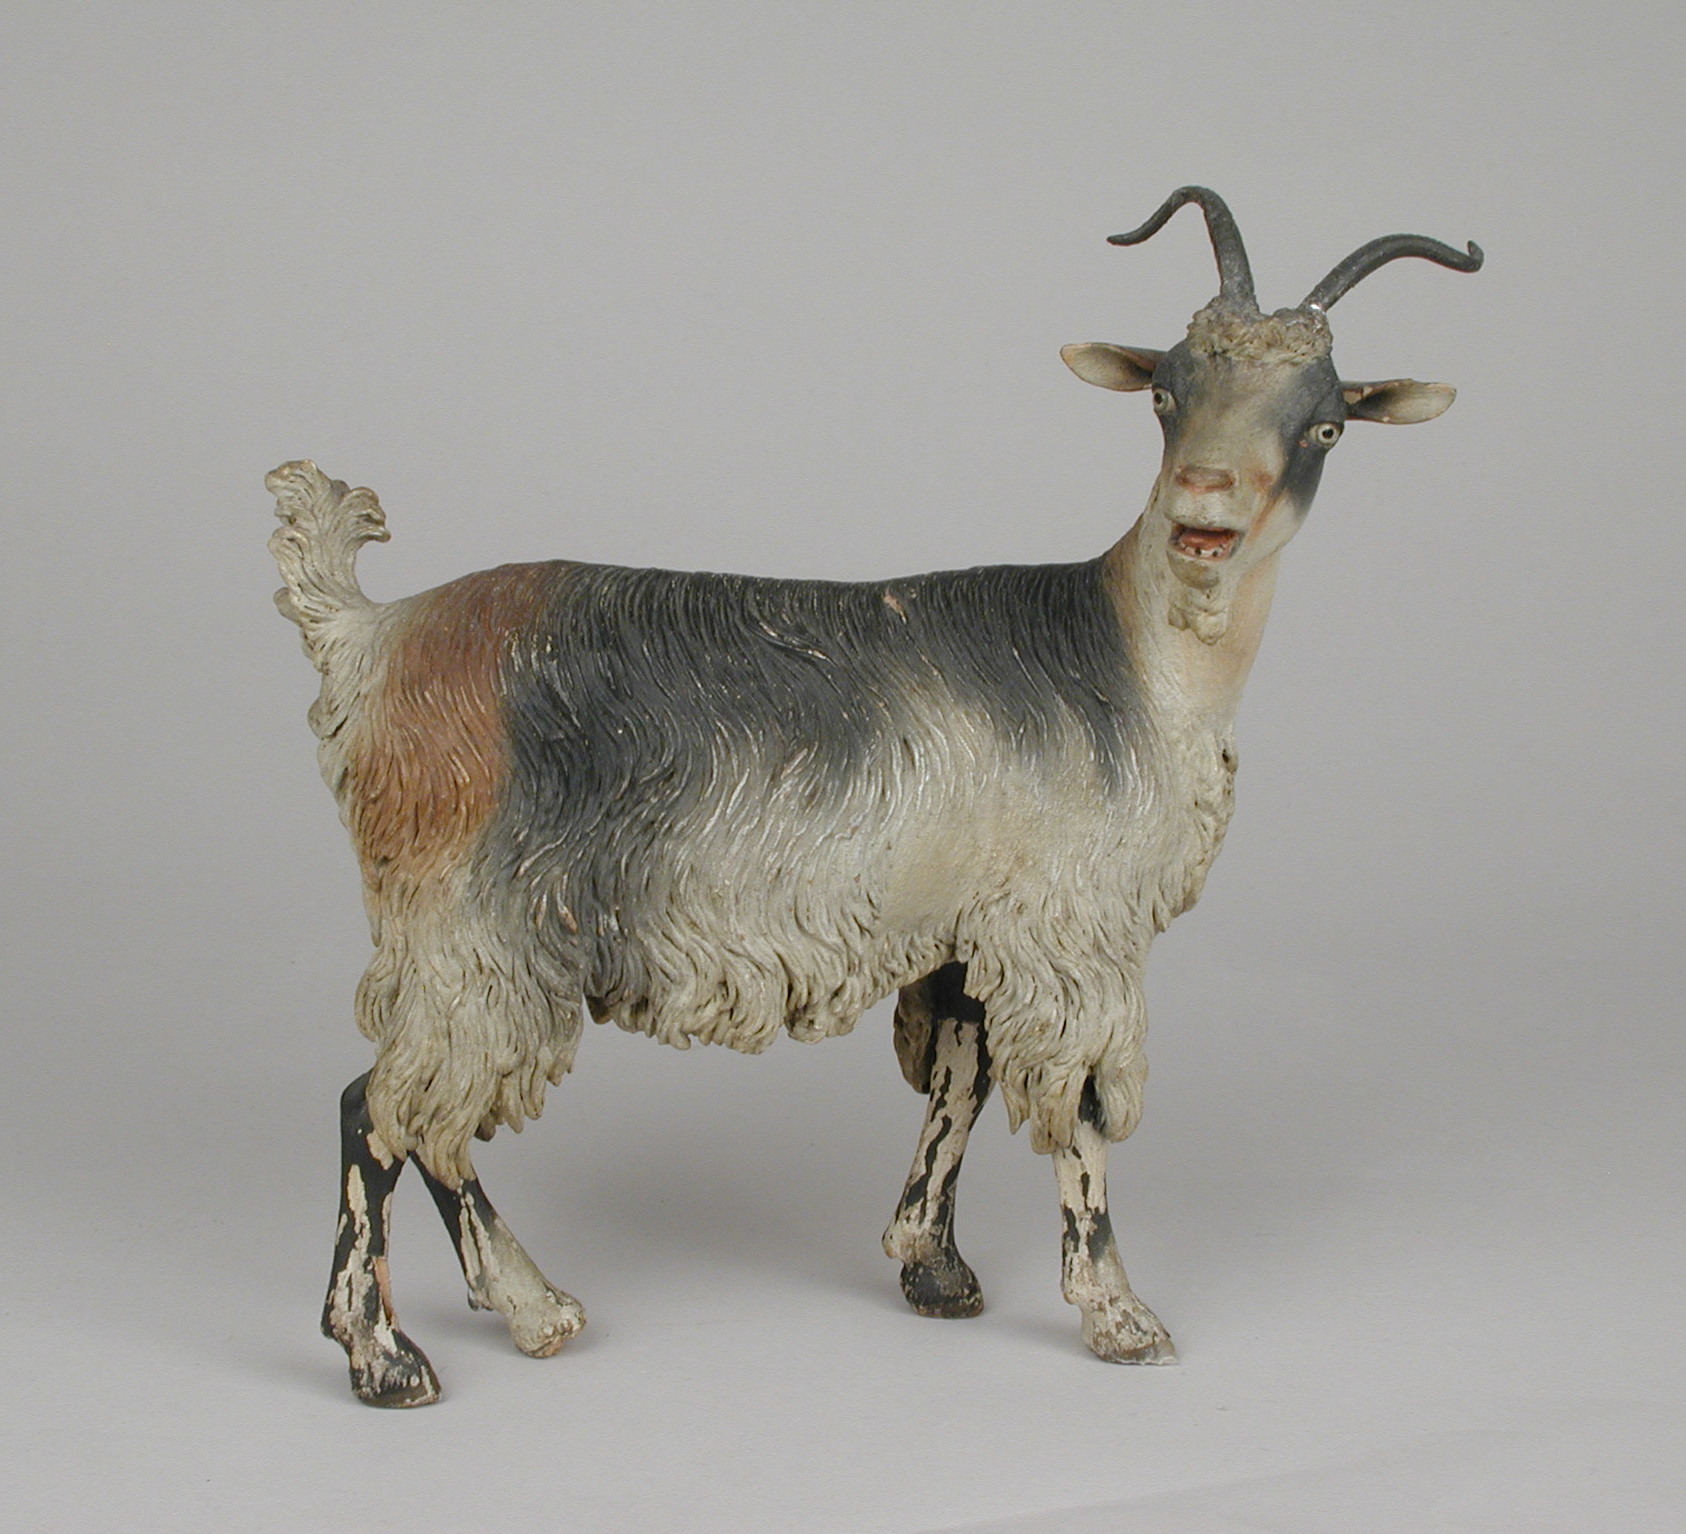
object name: crèche figure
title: Female adult goat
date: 1751-1800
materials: metal, terracotta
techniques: polychrome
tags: goats